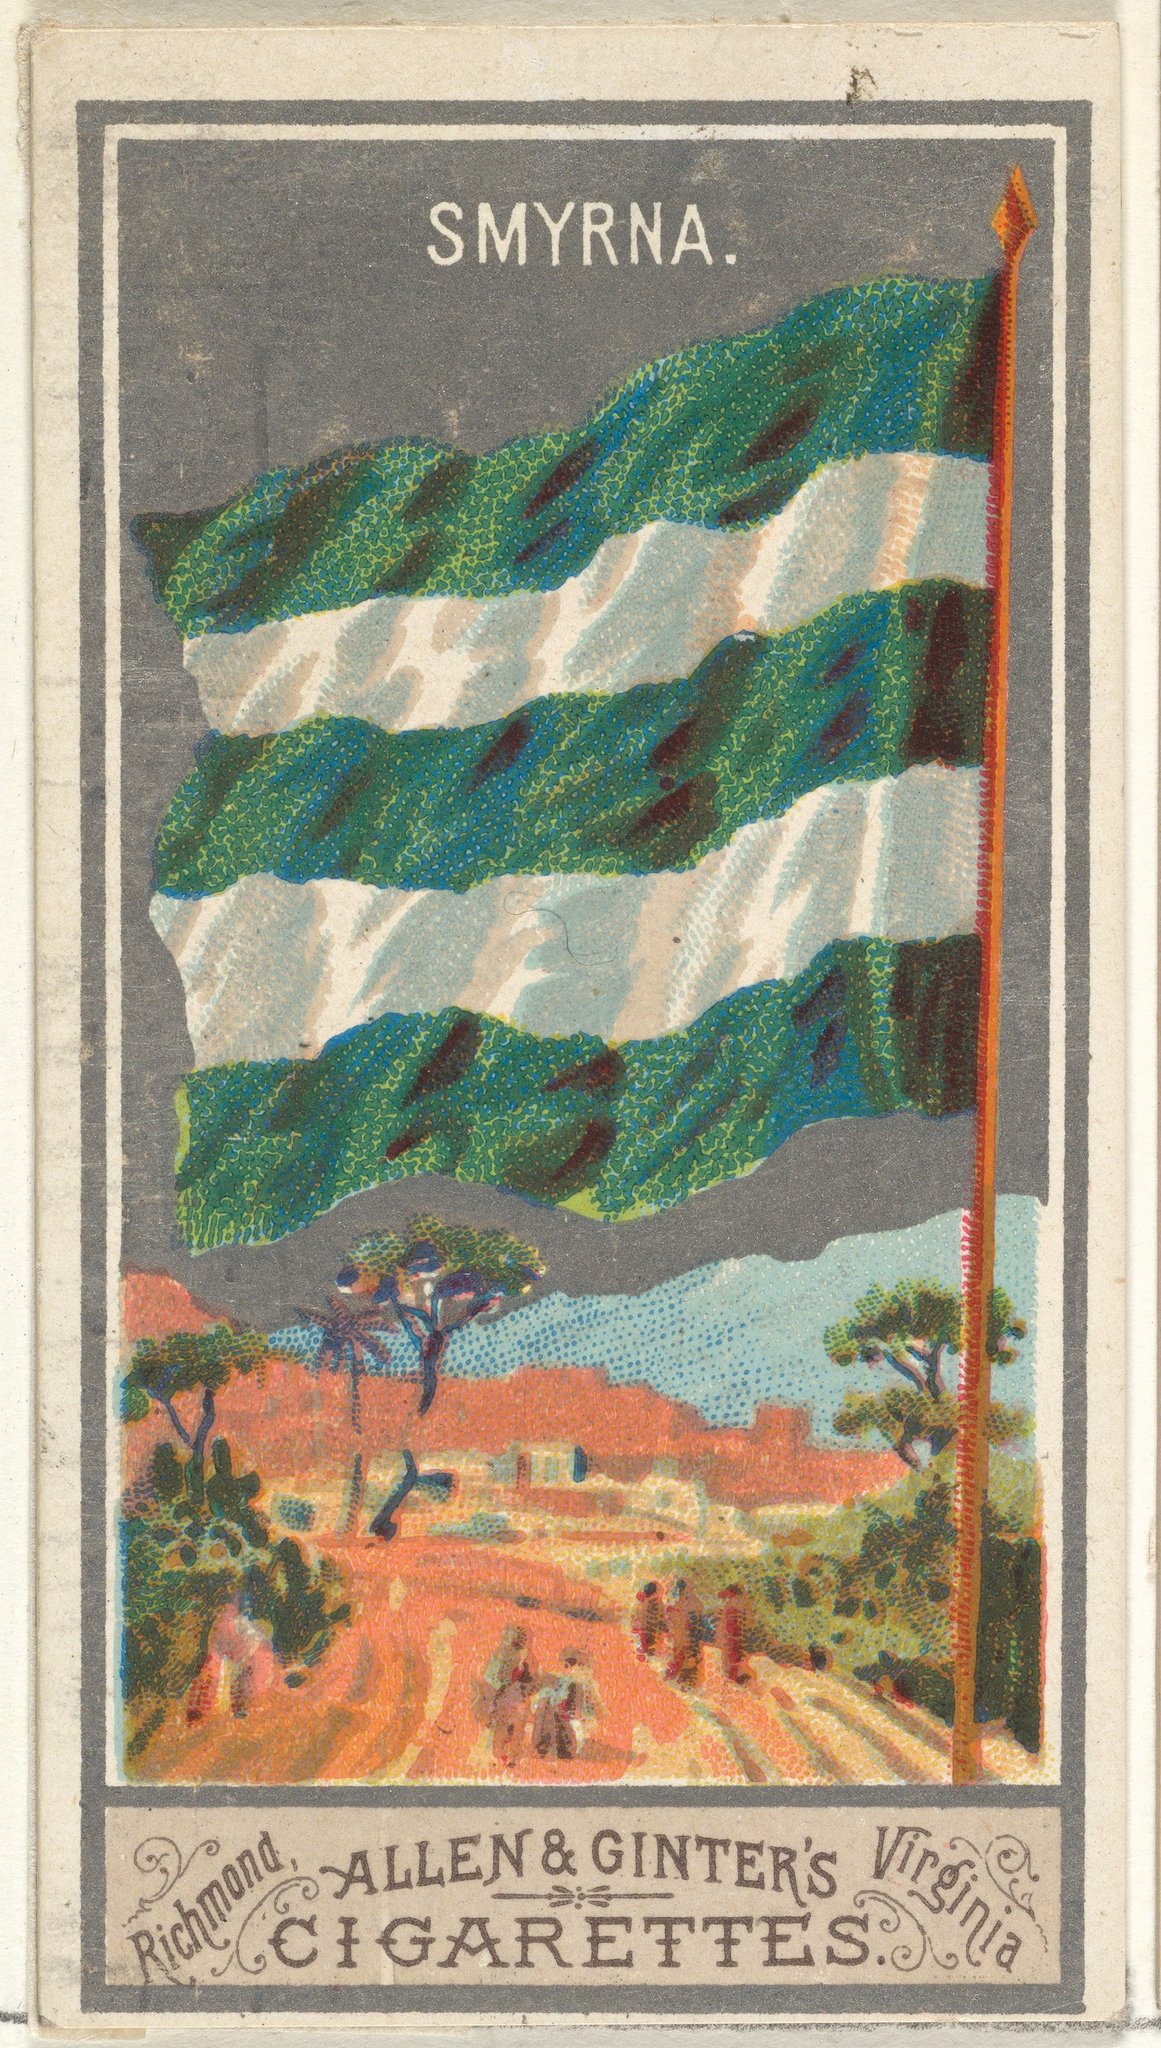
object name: print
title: Smyrna, from the City Flags series (N6) for Allen & Ginter Cigarettes Brands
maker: allen & ginter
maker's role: publisher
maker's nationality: american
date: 1887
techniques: color lithograph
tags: flags